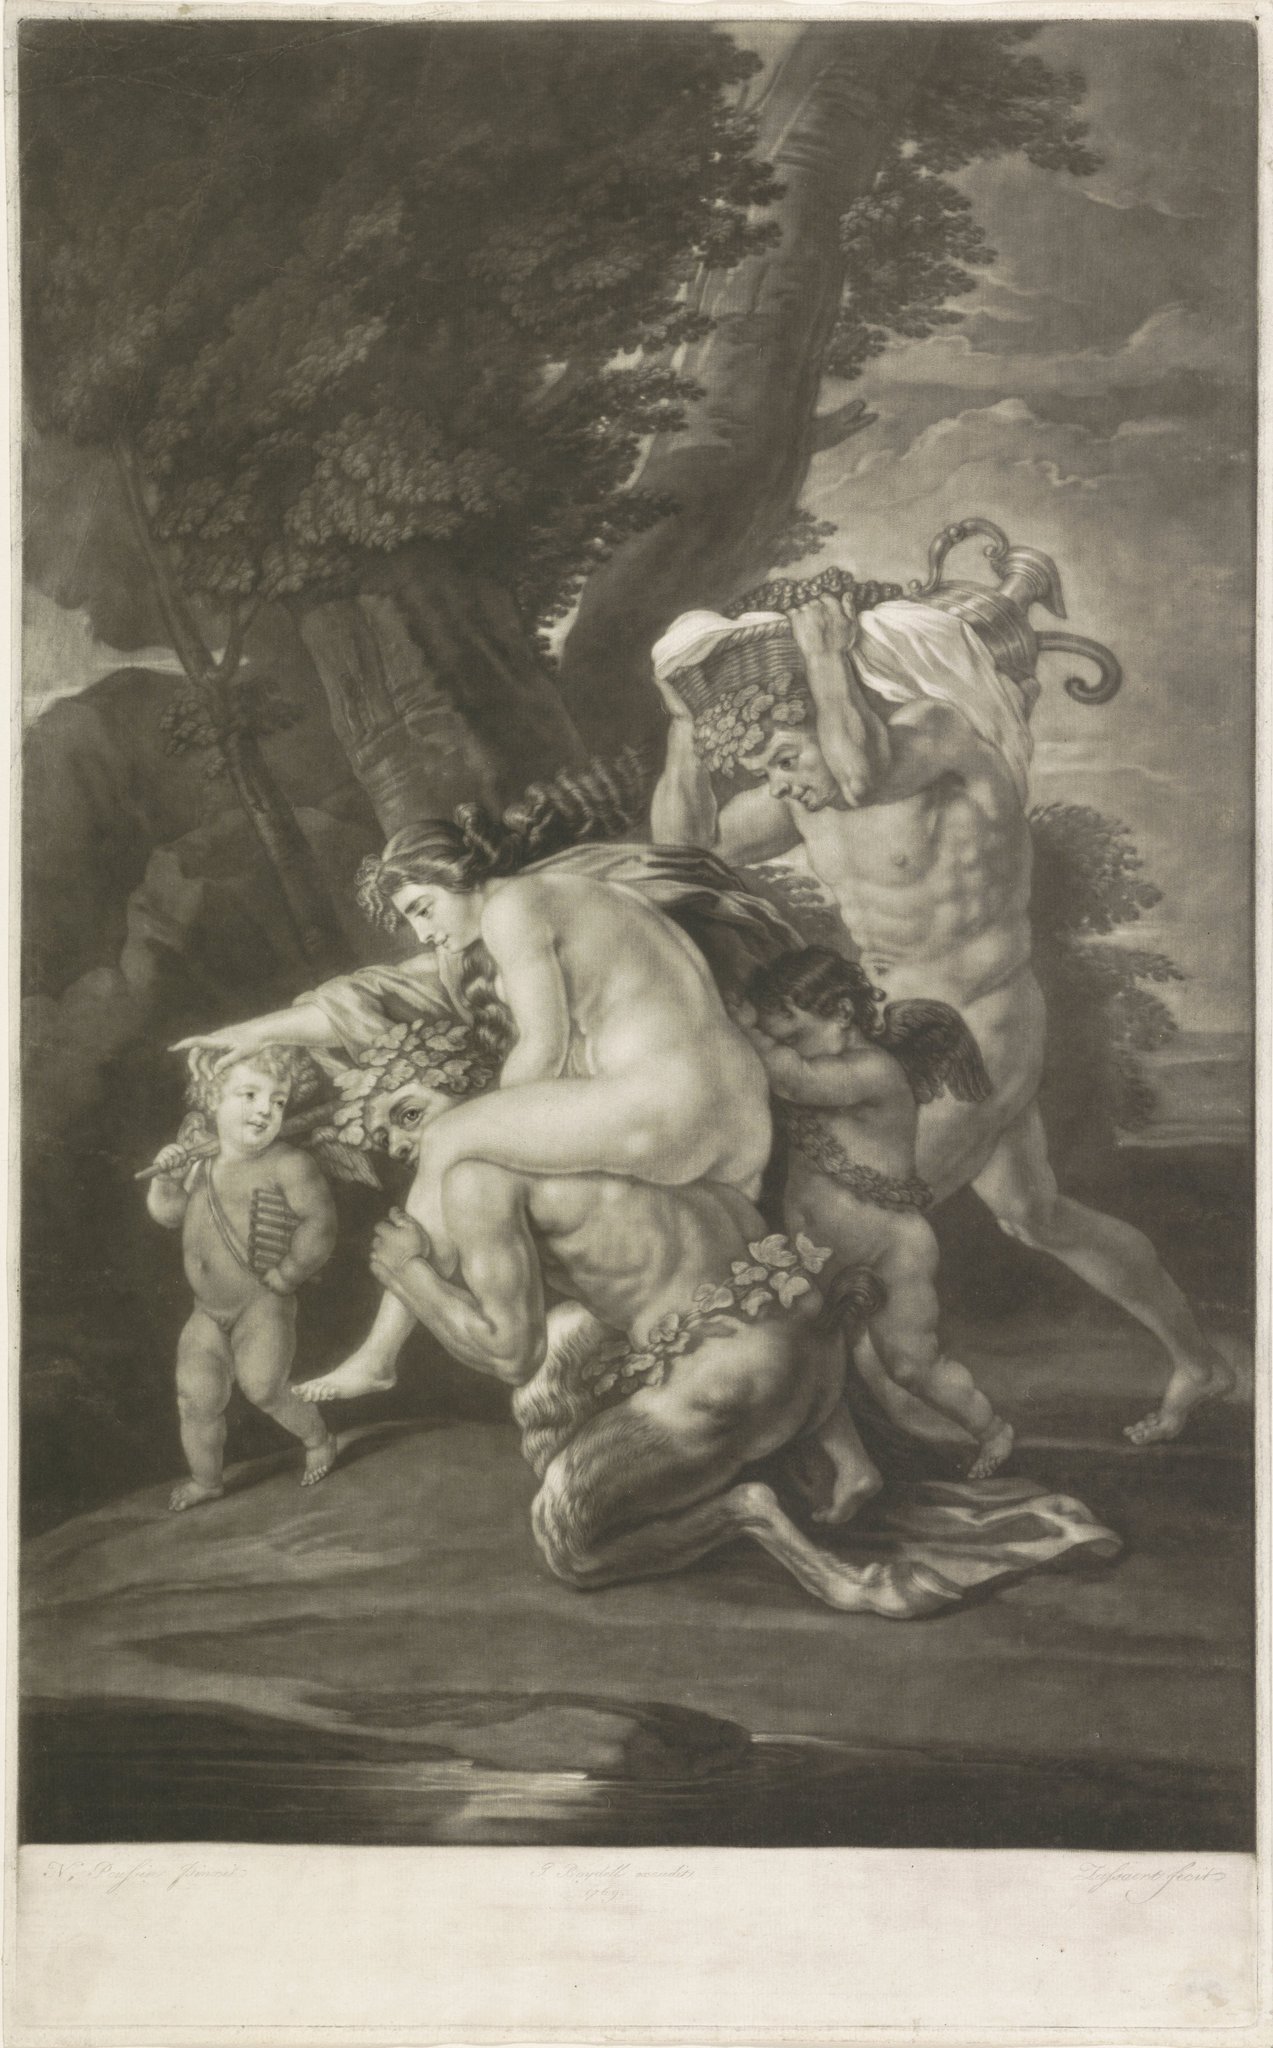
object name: print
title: Bacchanten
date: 1769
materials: paper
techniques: engraving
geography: london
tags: maenad(s), female bacchant(es), male bacchant(es), forest, wood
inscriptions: collector's mark: Lugt 2760, collector's mark: Lugt 2228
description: Naakte bachanten in een bos. Een jonge vrouw klimpt op de rug van een sater en wordt hierbij geholpen door een putto. Achter hen loopt een man met een mand op zijn rug die is gevuld met wijn en druiven.